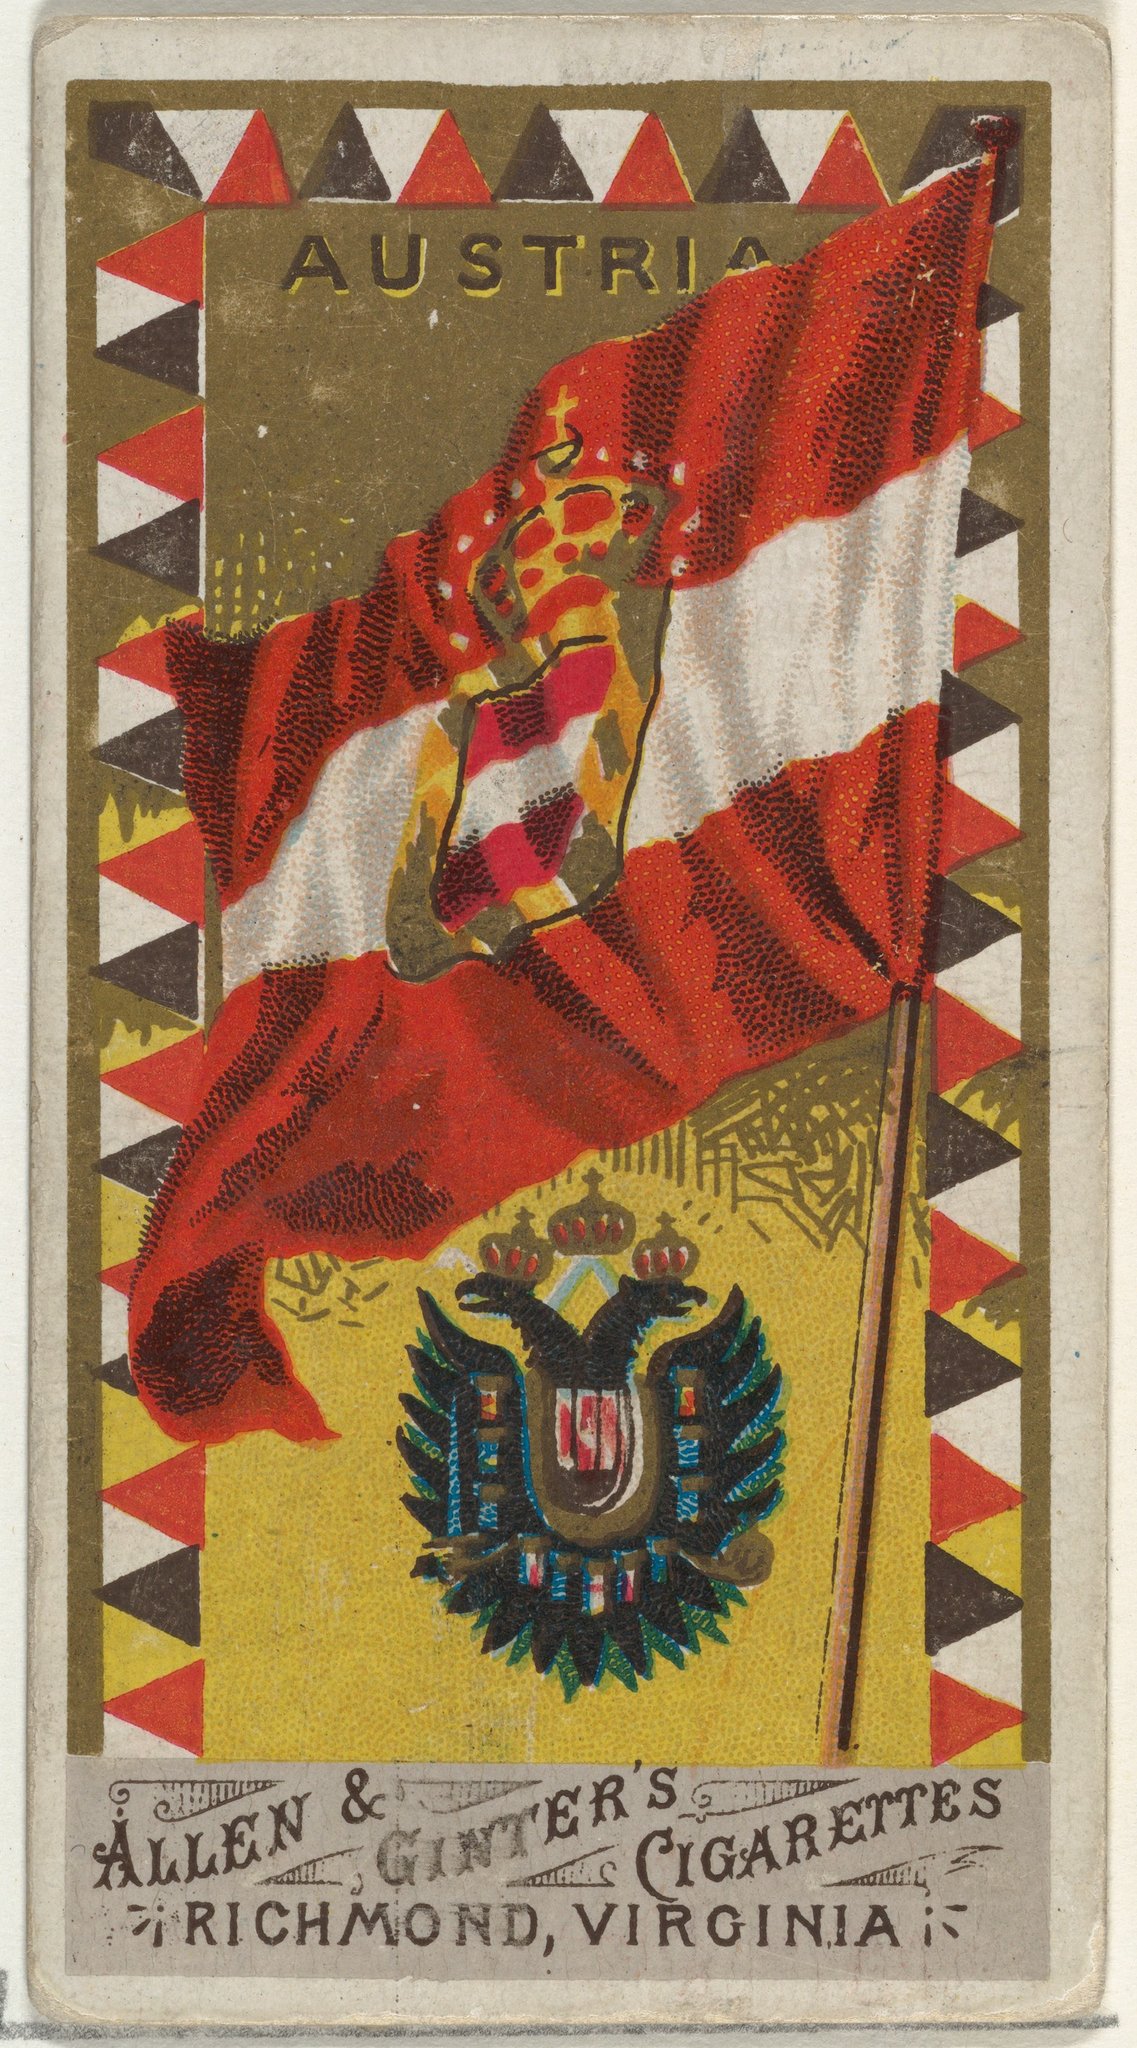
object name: print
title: Austria, from Flags of All Nations, Series 1 (N9) for Allen & Ginter Cigarettes Brands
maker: allen & ginter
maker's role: publisher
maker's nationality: american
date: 1887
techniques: color lithograph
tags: coat of arms,flags